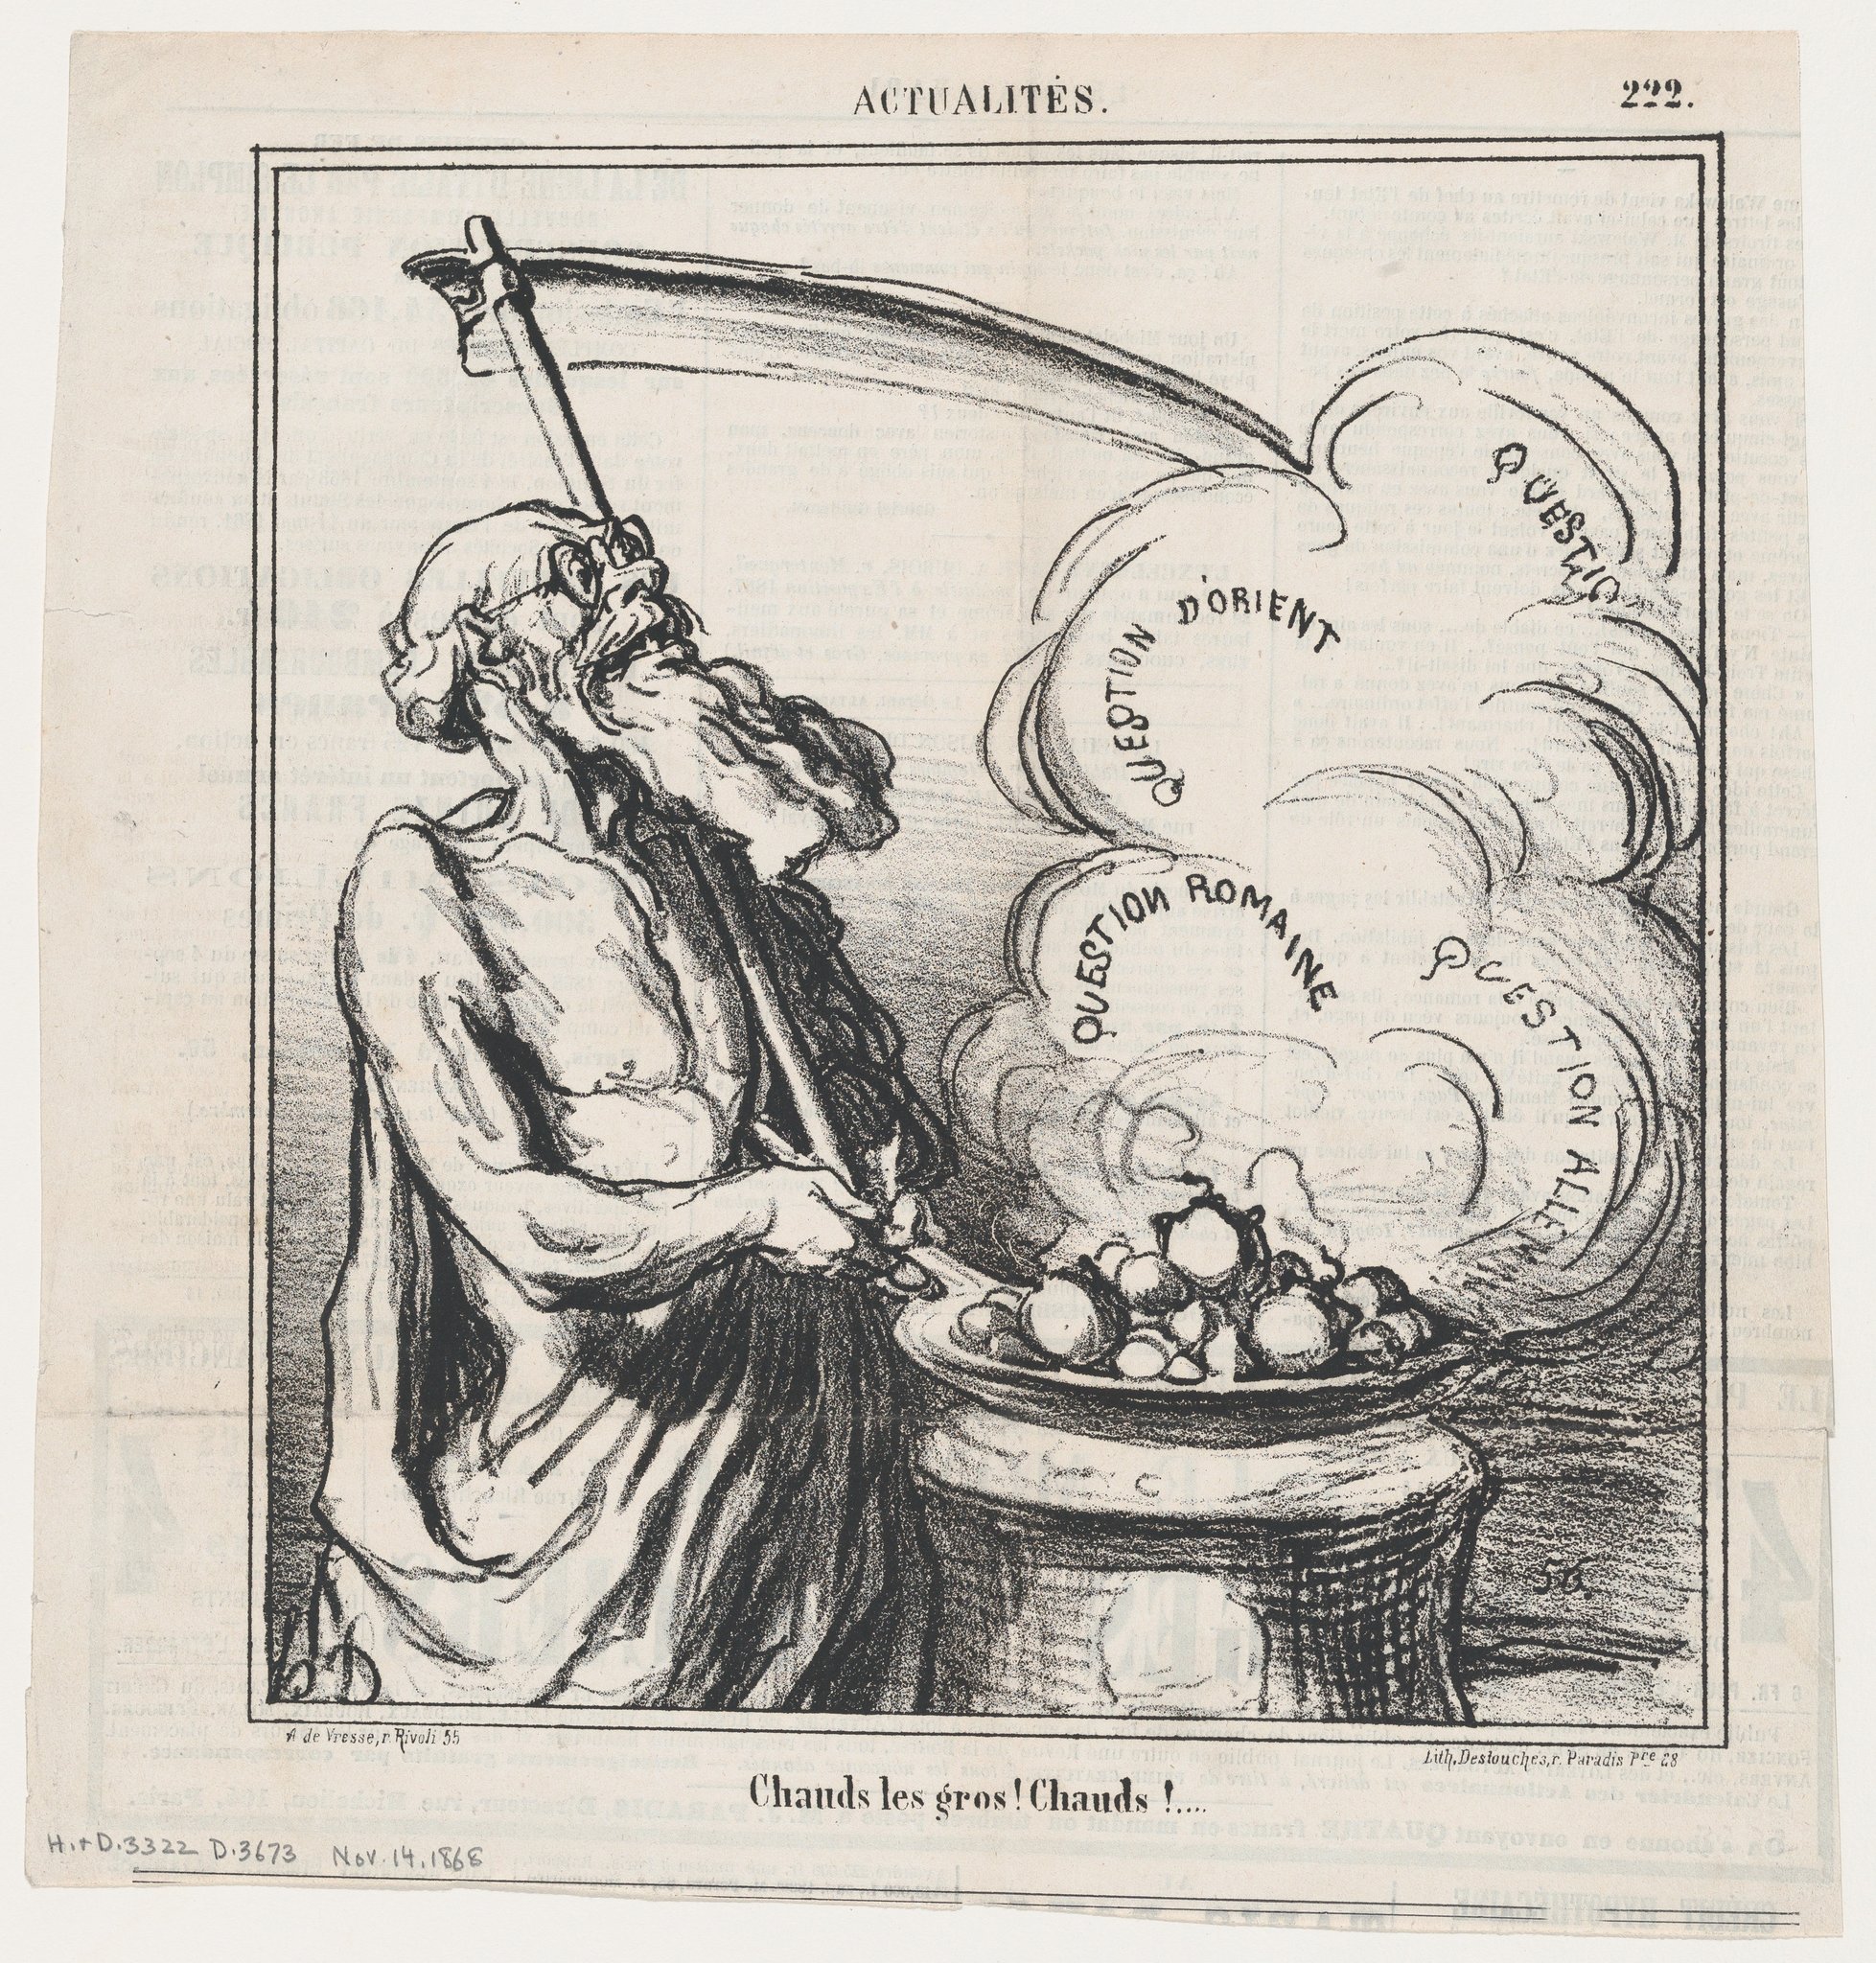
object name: print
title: Big hot ones! Hot!, from 'News of the day,' published in Le Charivari, November 14, 1868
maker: honoré daumier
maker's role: artist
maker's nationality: french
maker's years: 1808-1879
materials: paper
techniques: lithograph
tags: satire,men